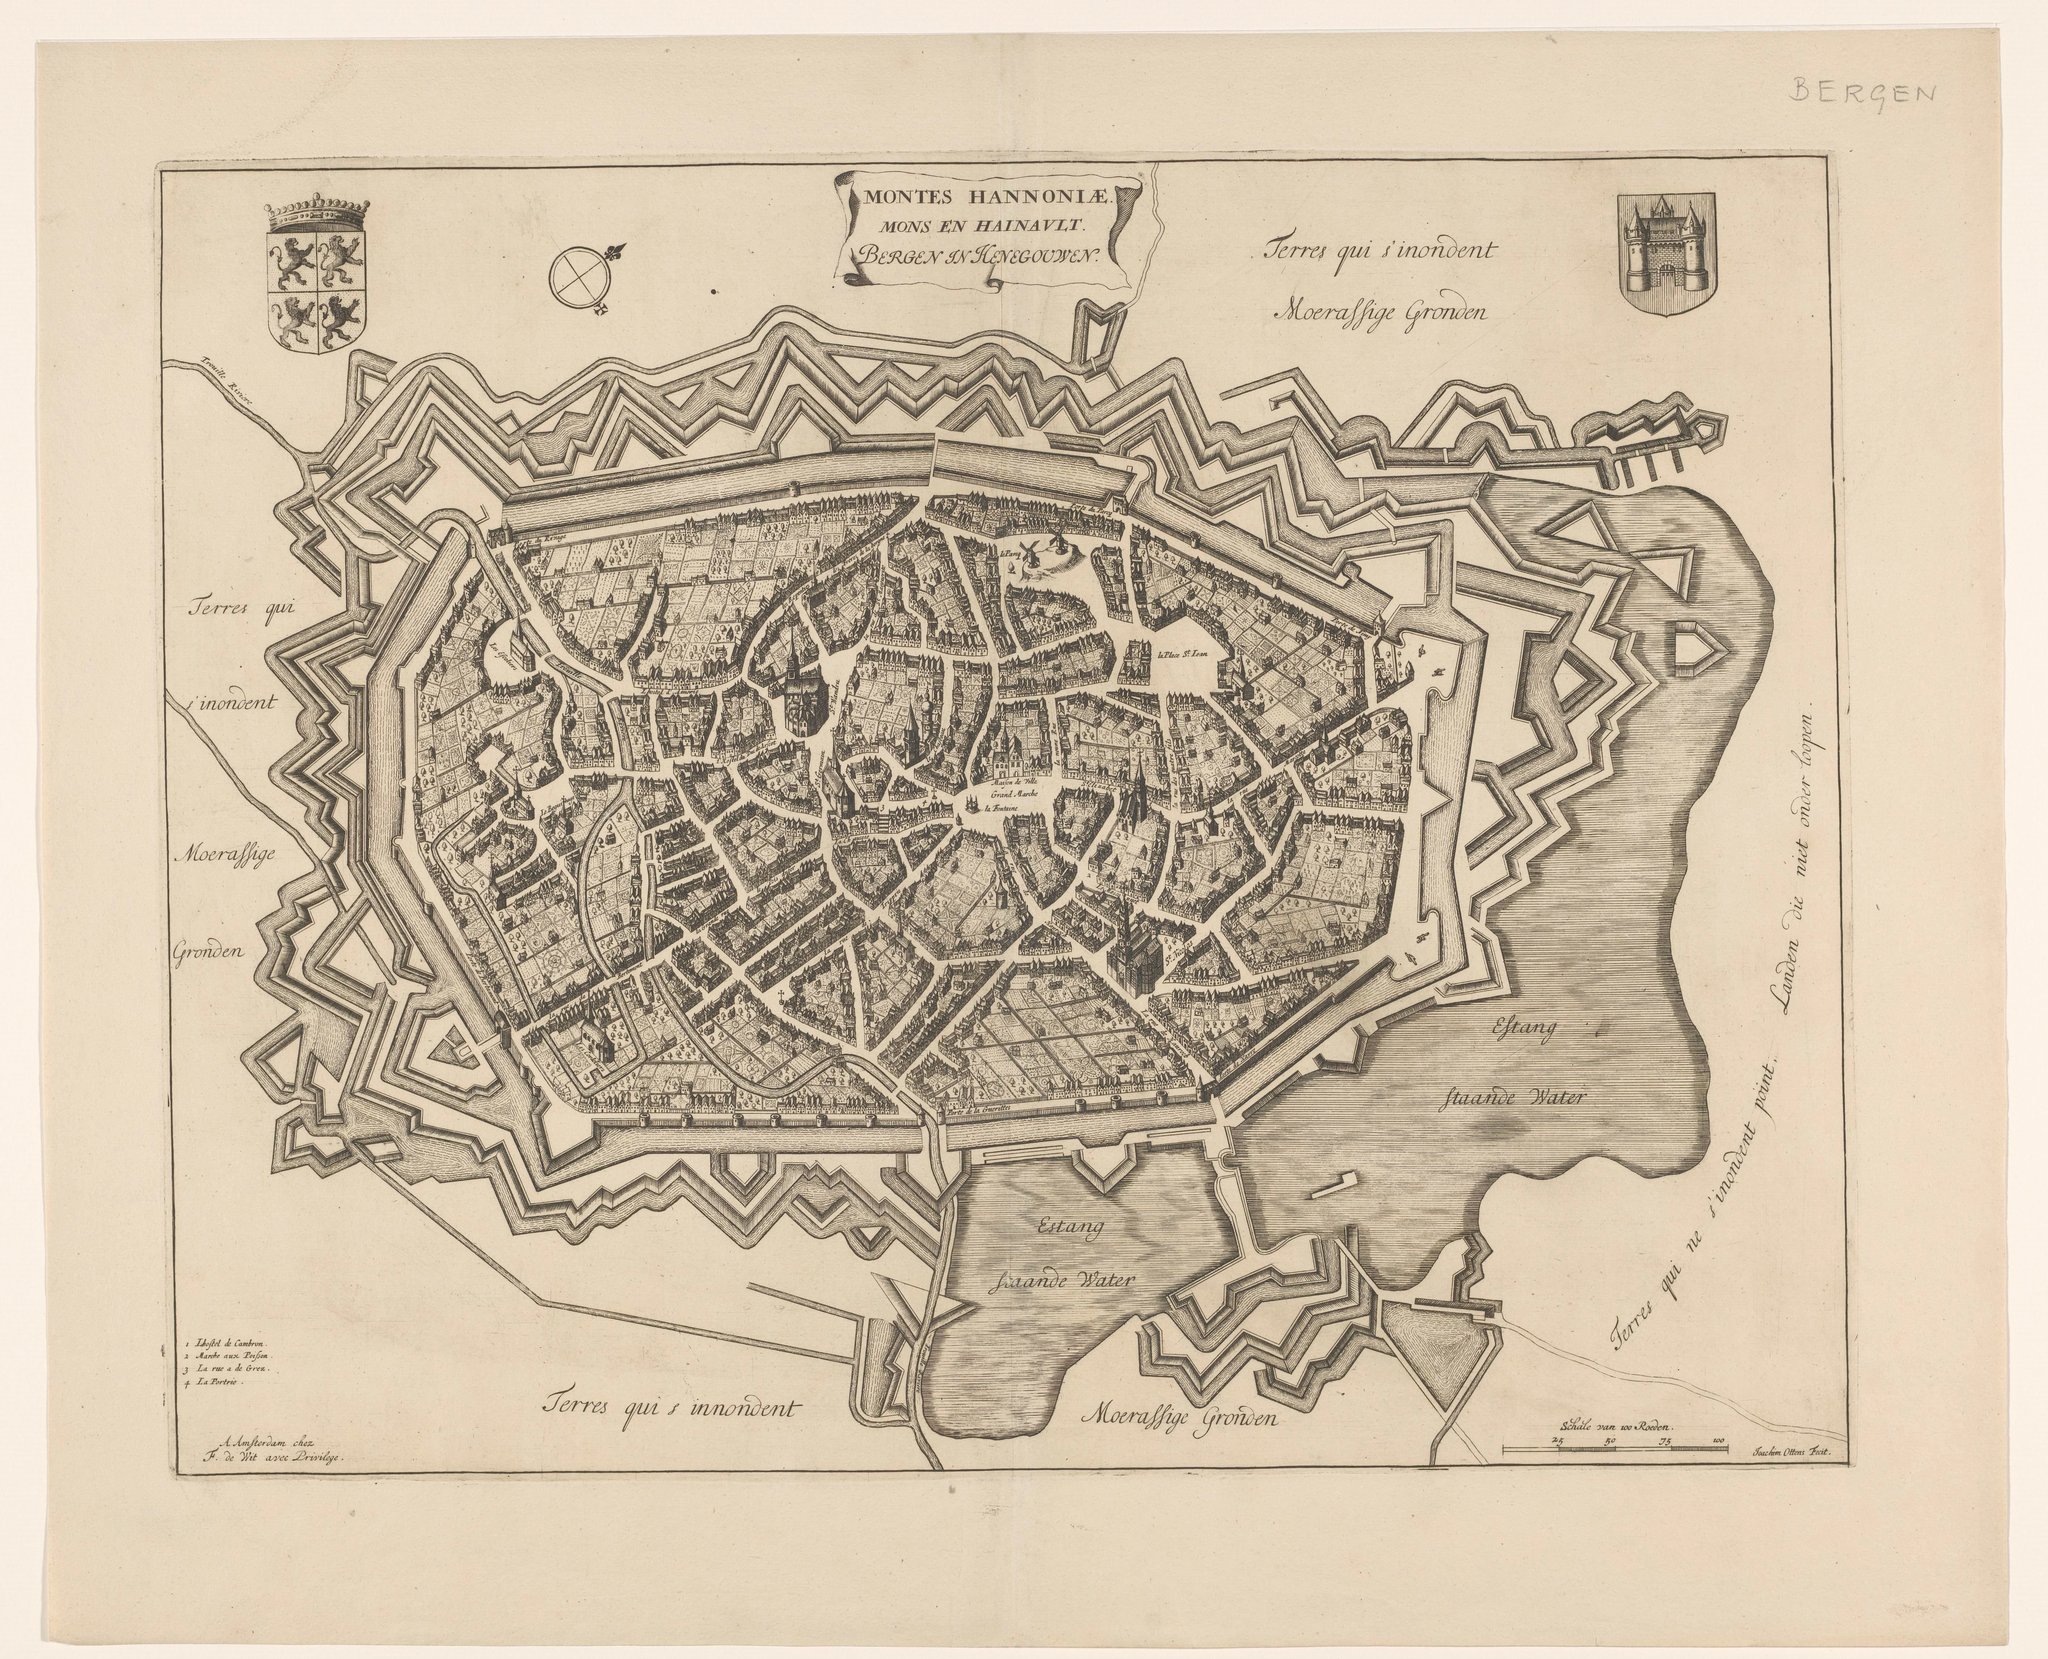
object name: print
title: Plattegrond van Bergen (Mons)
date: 1698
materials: paper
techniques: engraving, etching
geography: amsterdam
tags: coat of arms (as symbol of the state, etc.) (+ city; municipal), fortified city, maps of cities, coat of arms (as symbol of the state, etc.) (+ province; provincial)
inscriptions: collector's mark: Lugt 2228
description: Plattegrond van Bergen (Mons) met gebouwen in vogelvluchtperspectief. Boven, in het midden, de titelcartouche. Rechtsonder een schaalstok: Schale van 100 Roeden. Linksonder een legenda 1-4. Linksboven het wapen van Henegouwen, rechtsboven het wapen van Bergen.